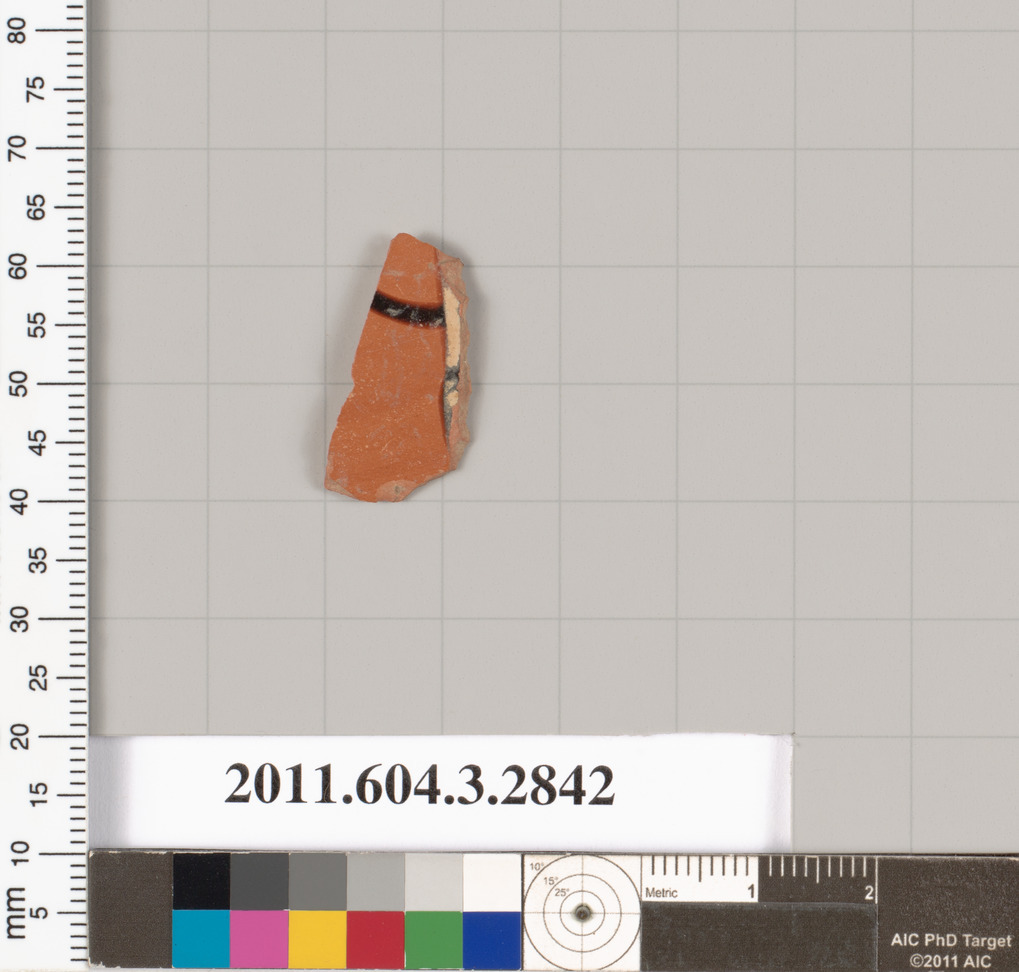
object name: undetermined closed shape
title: Terracotta fragment of a closed shape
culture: greek, attic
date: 534-468 BCE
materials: terracotta